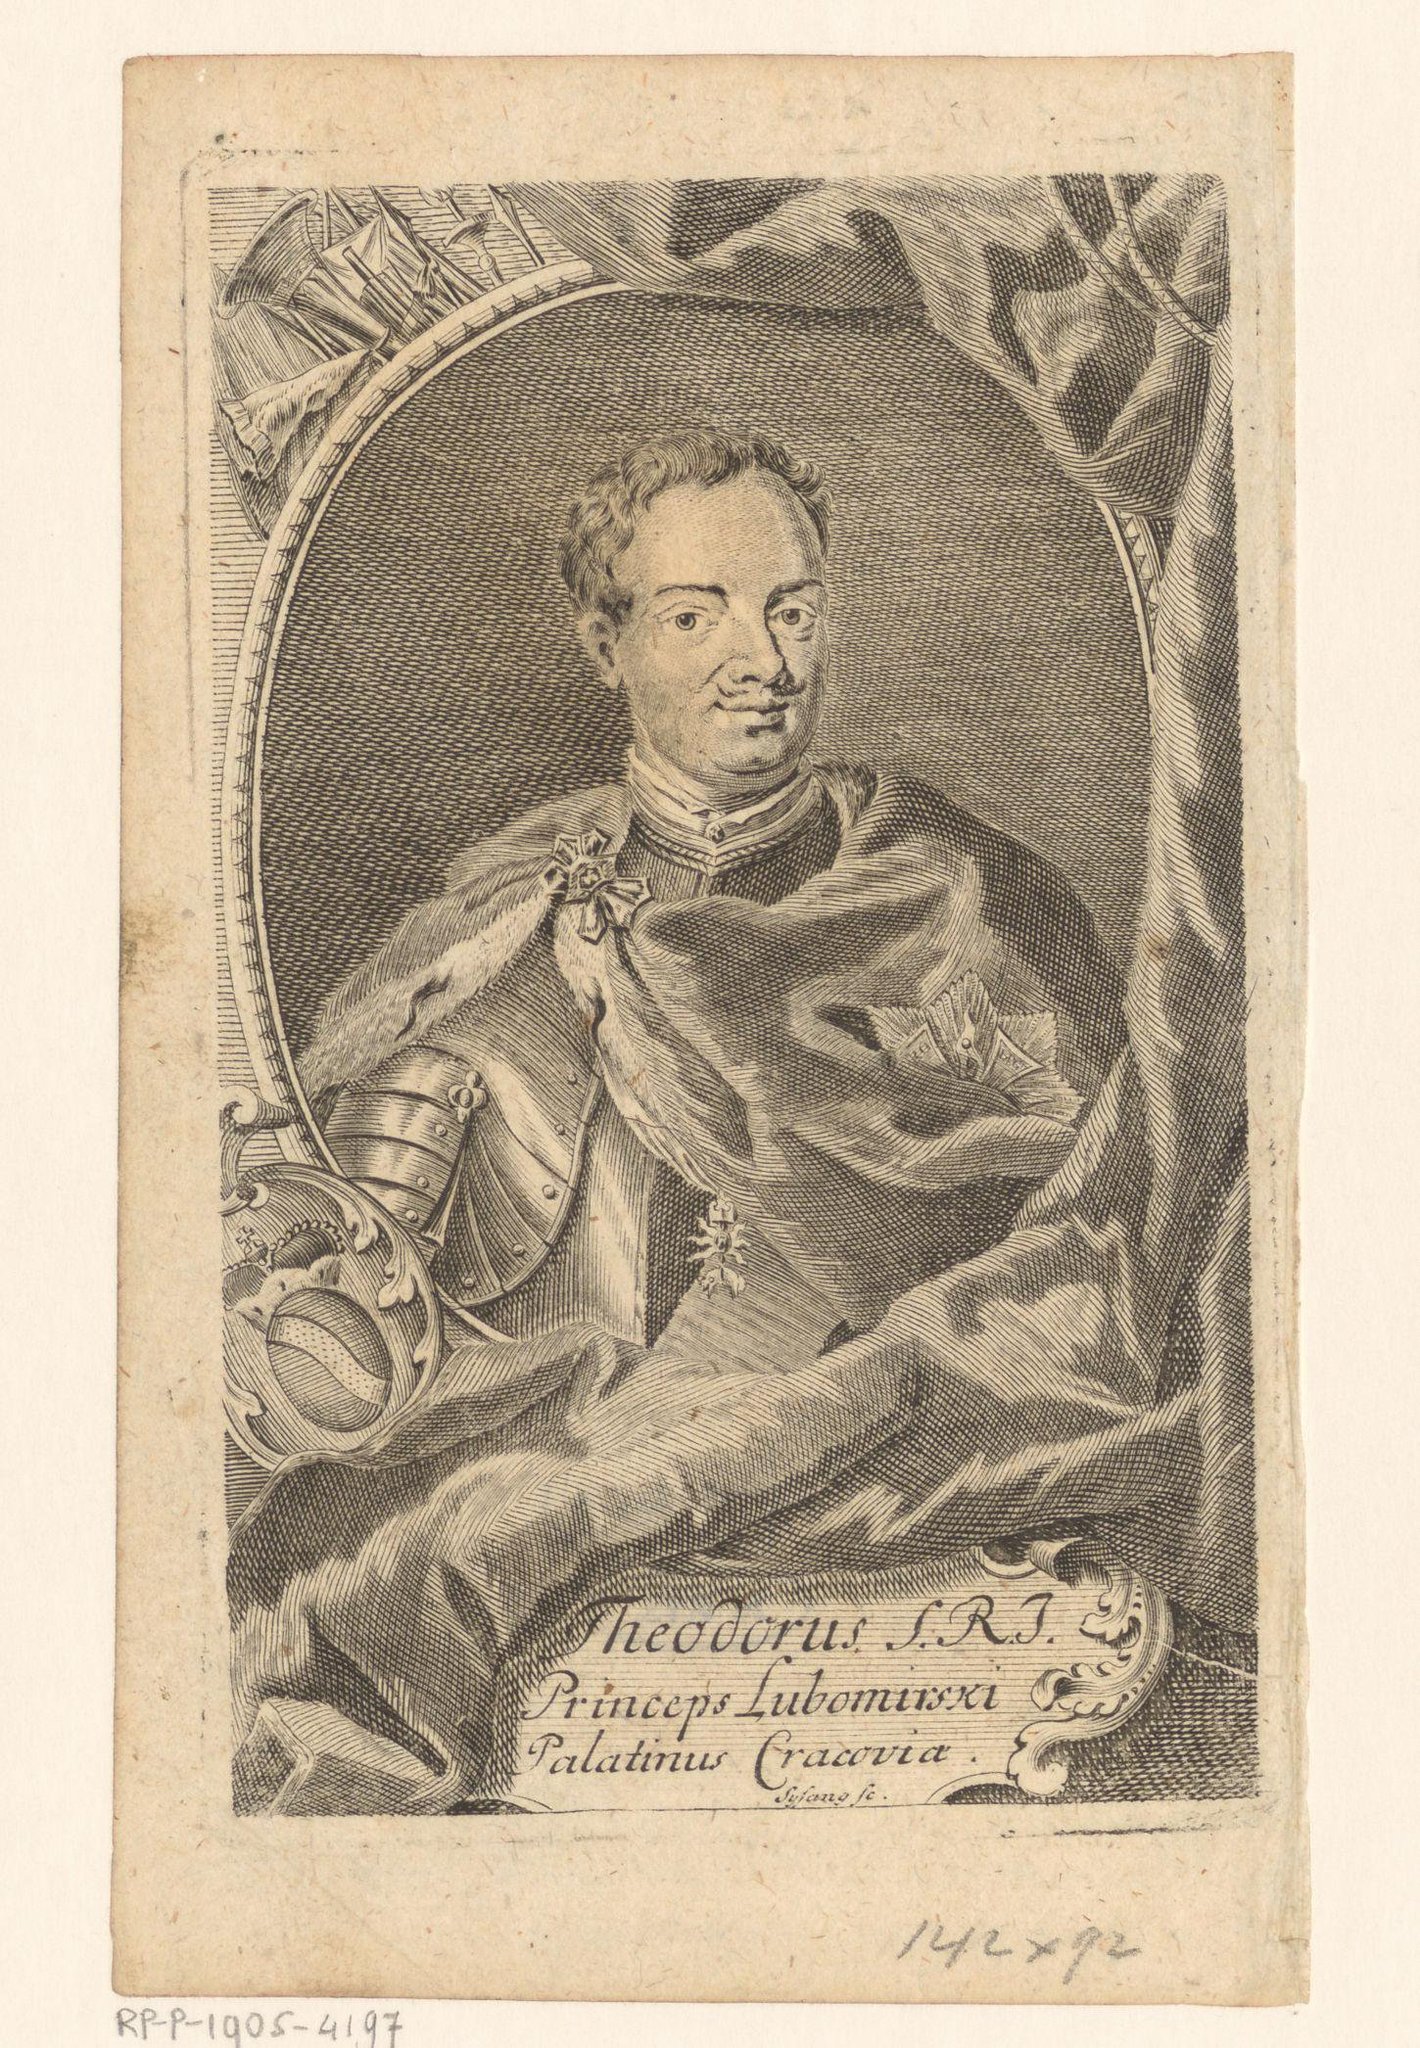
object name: print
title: Portret van Teodor, Fürst Lubomirski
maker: johann christoph sysang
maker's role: print maker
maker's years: 1703-1757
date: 1735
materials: paper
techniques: engraving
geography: germany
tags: armour, historical persons, knighthood order of the golden fleece - insignia of a knighthood order, e.g.: badge, chain (with name of order), armorial bearing, heraldry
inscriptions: collector's mark: Lugt 2228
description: Prent gebruikt voor de publicatie: Europäischer Staats-Secretarius. Leipzig: Moritz Georg II Weidmann, 1735, dl. 11.